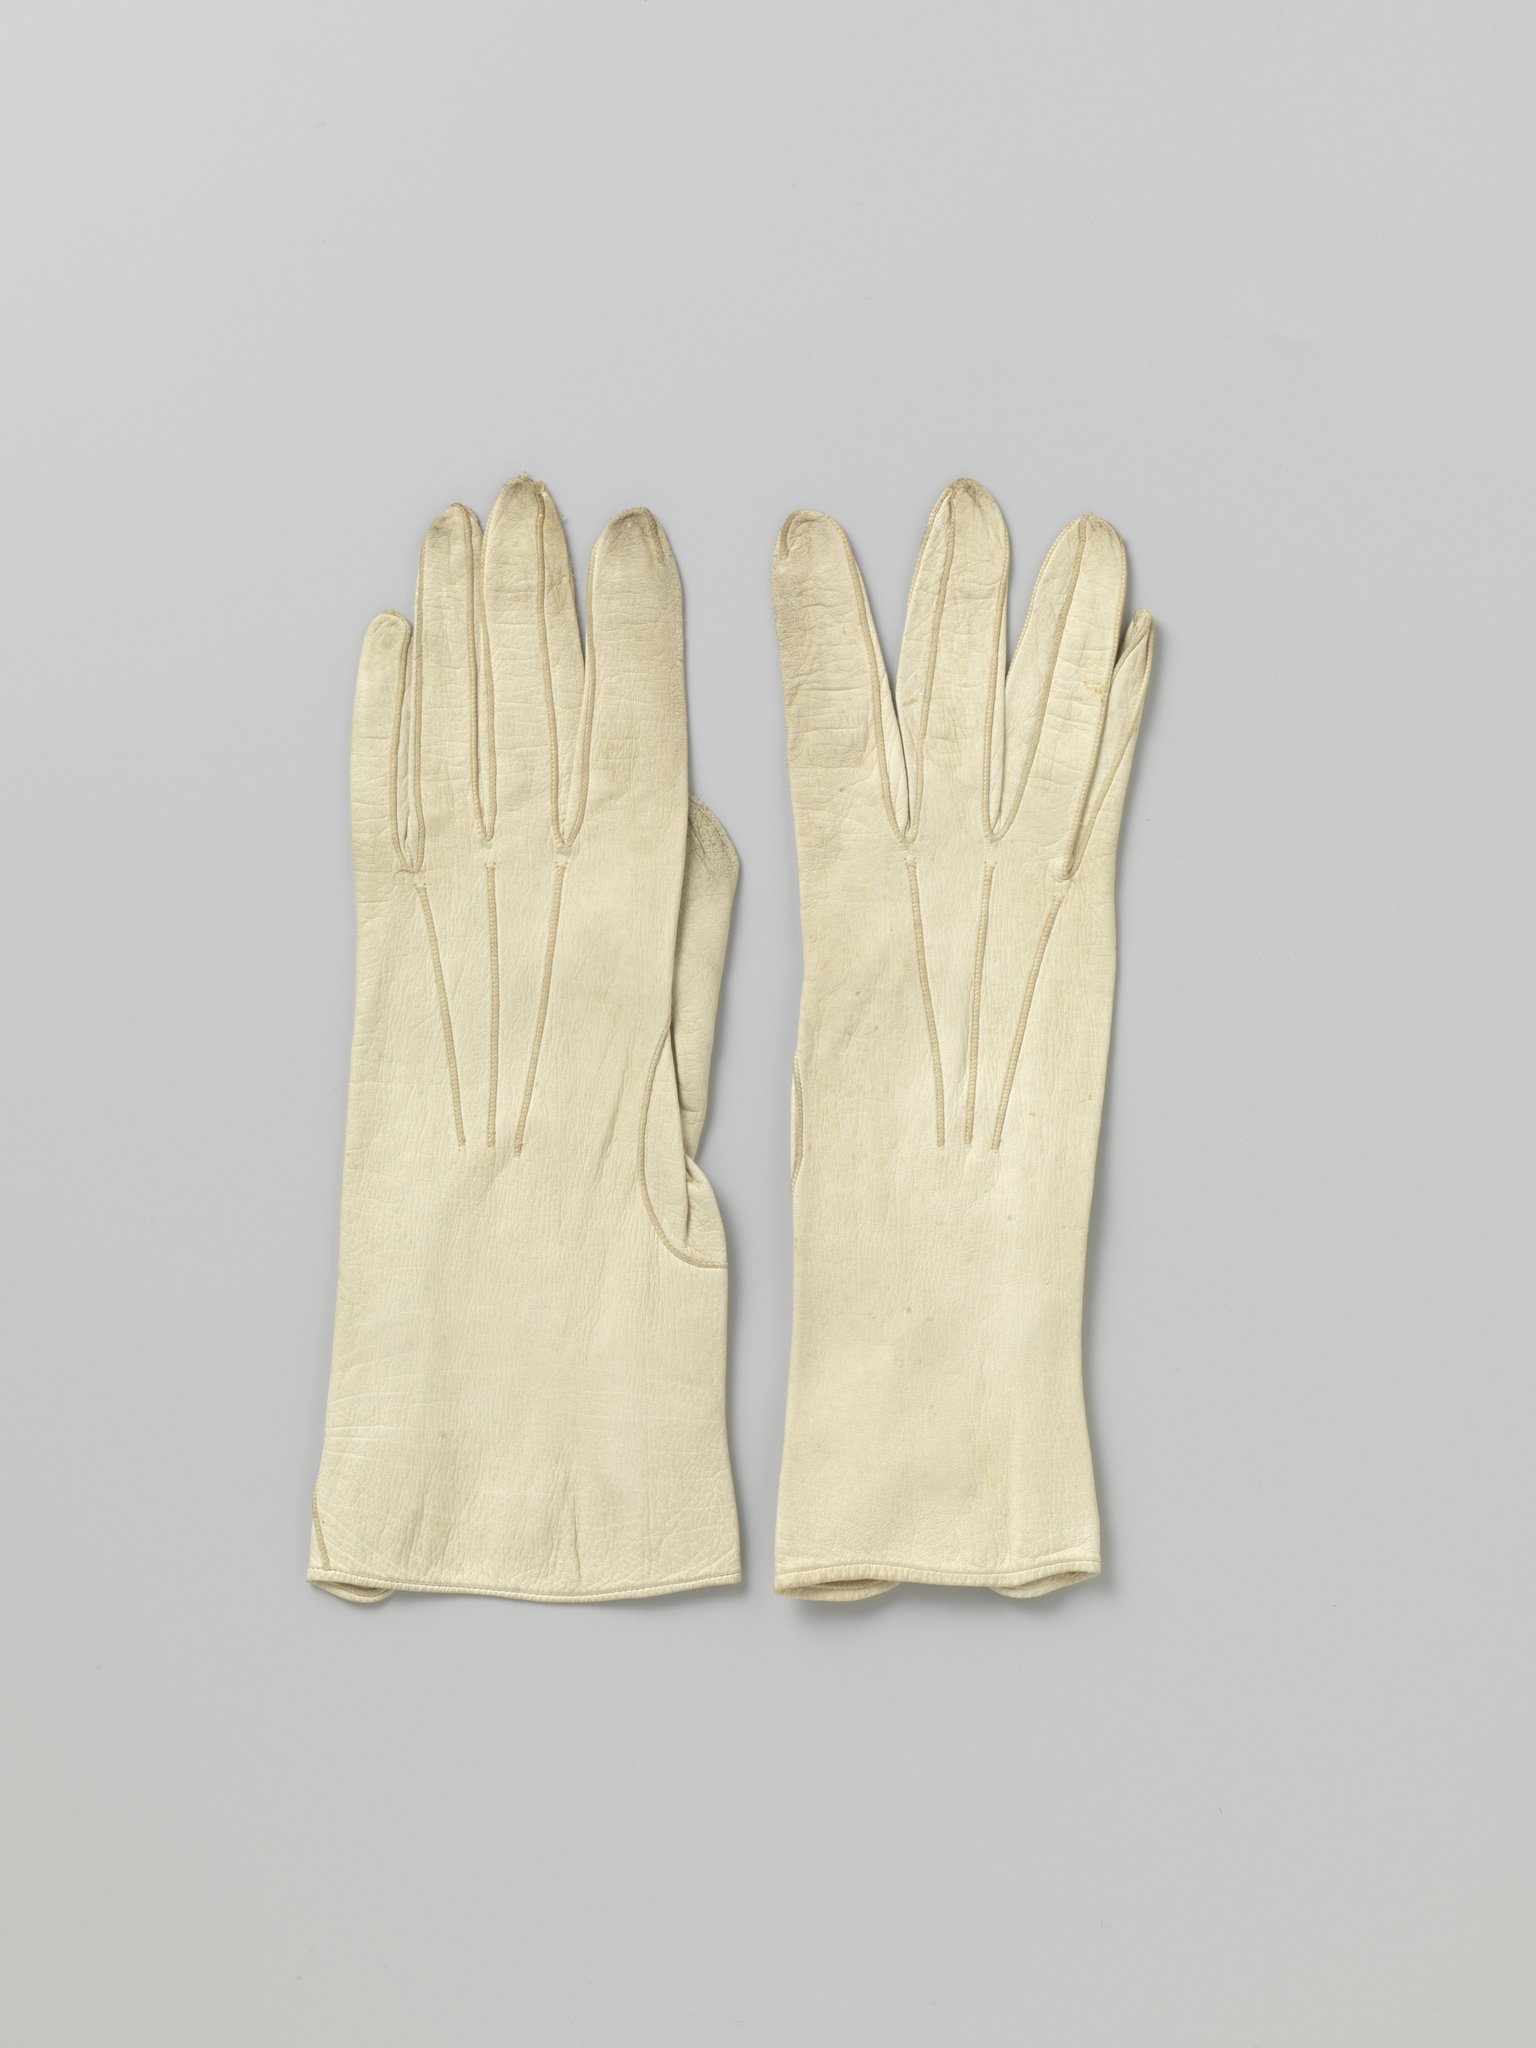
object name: clothing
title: Handschoen van wit leer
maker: Anonymous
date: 1900-1925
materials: leather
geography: western europe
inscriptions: size: ‘TvB 3/93 4’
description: Rechterhandschoen van wit leer, sluiting met twee met leer beklede drukknopen.